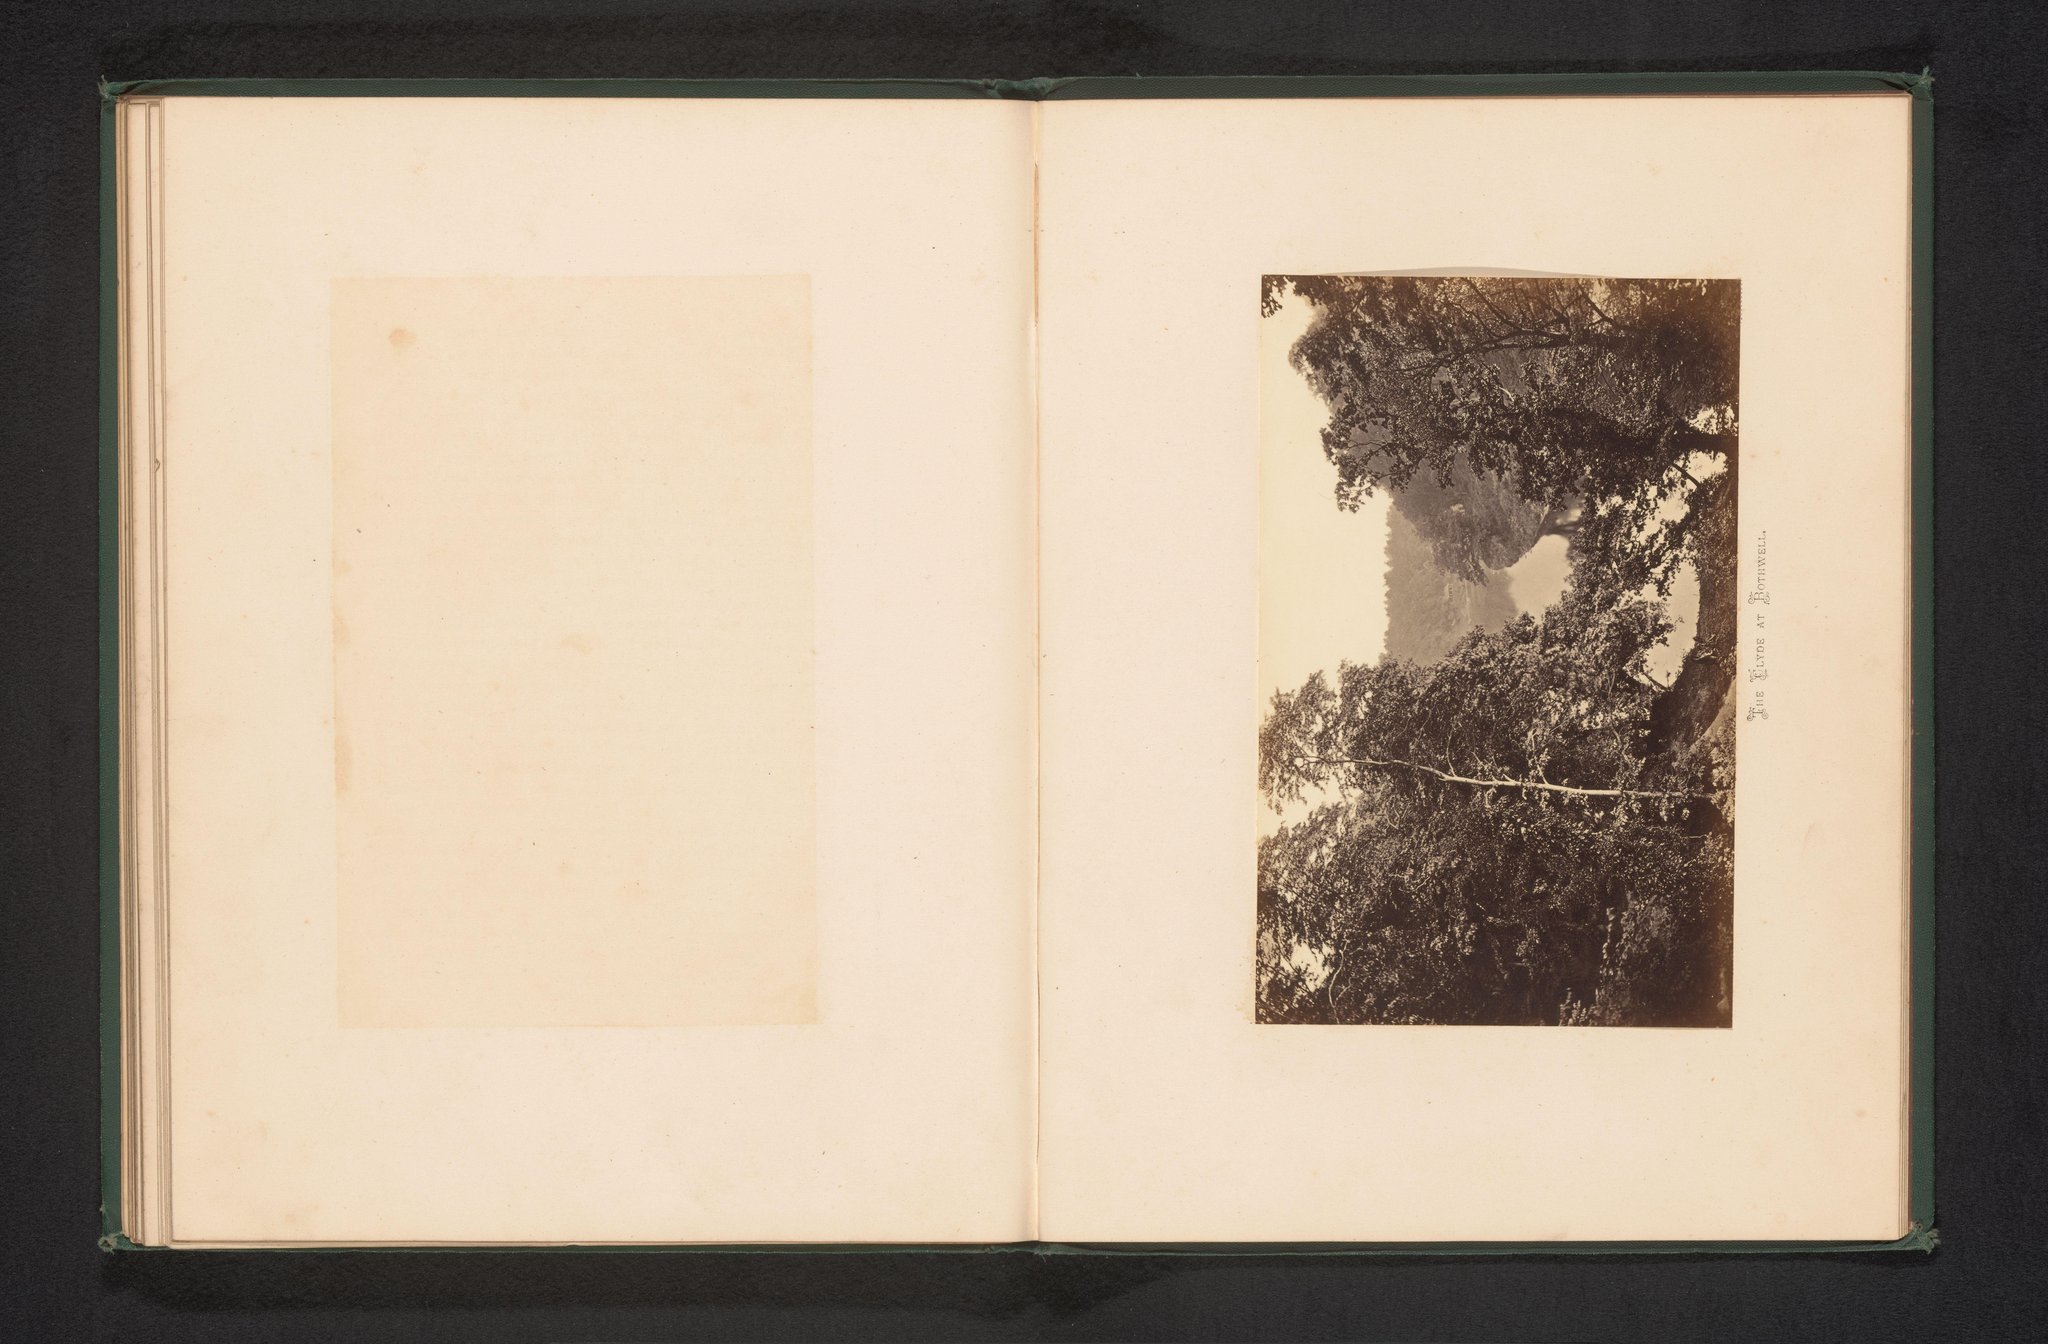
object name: page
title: Gezicht op de Clyde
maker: Anonymous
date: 1862-1867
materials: photographic support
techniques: albumen print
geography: south lanarkshire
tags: river, landscapes with waters, waterscapes, seascapes (in the temperate zone)